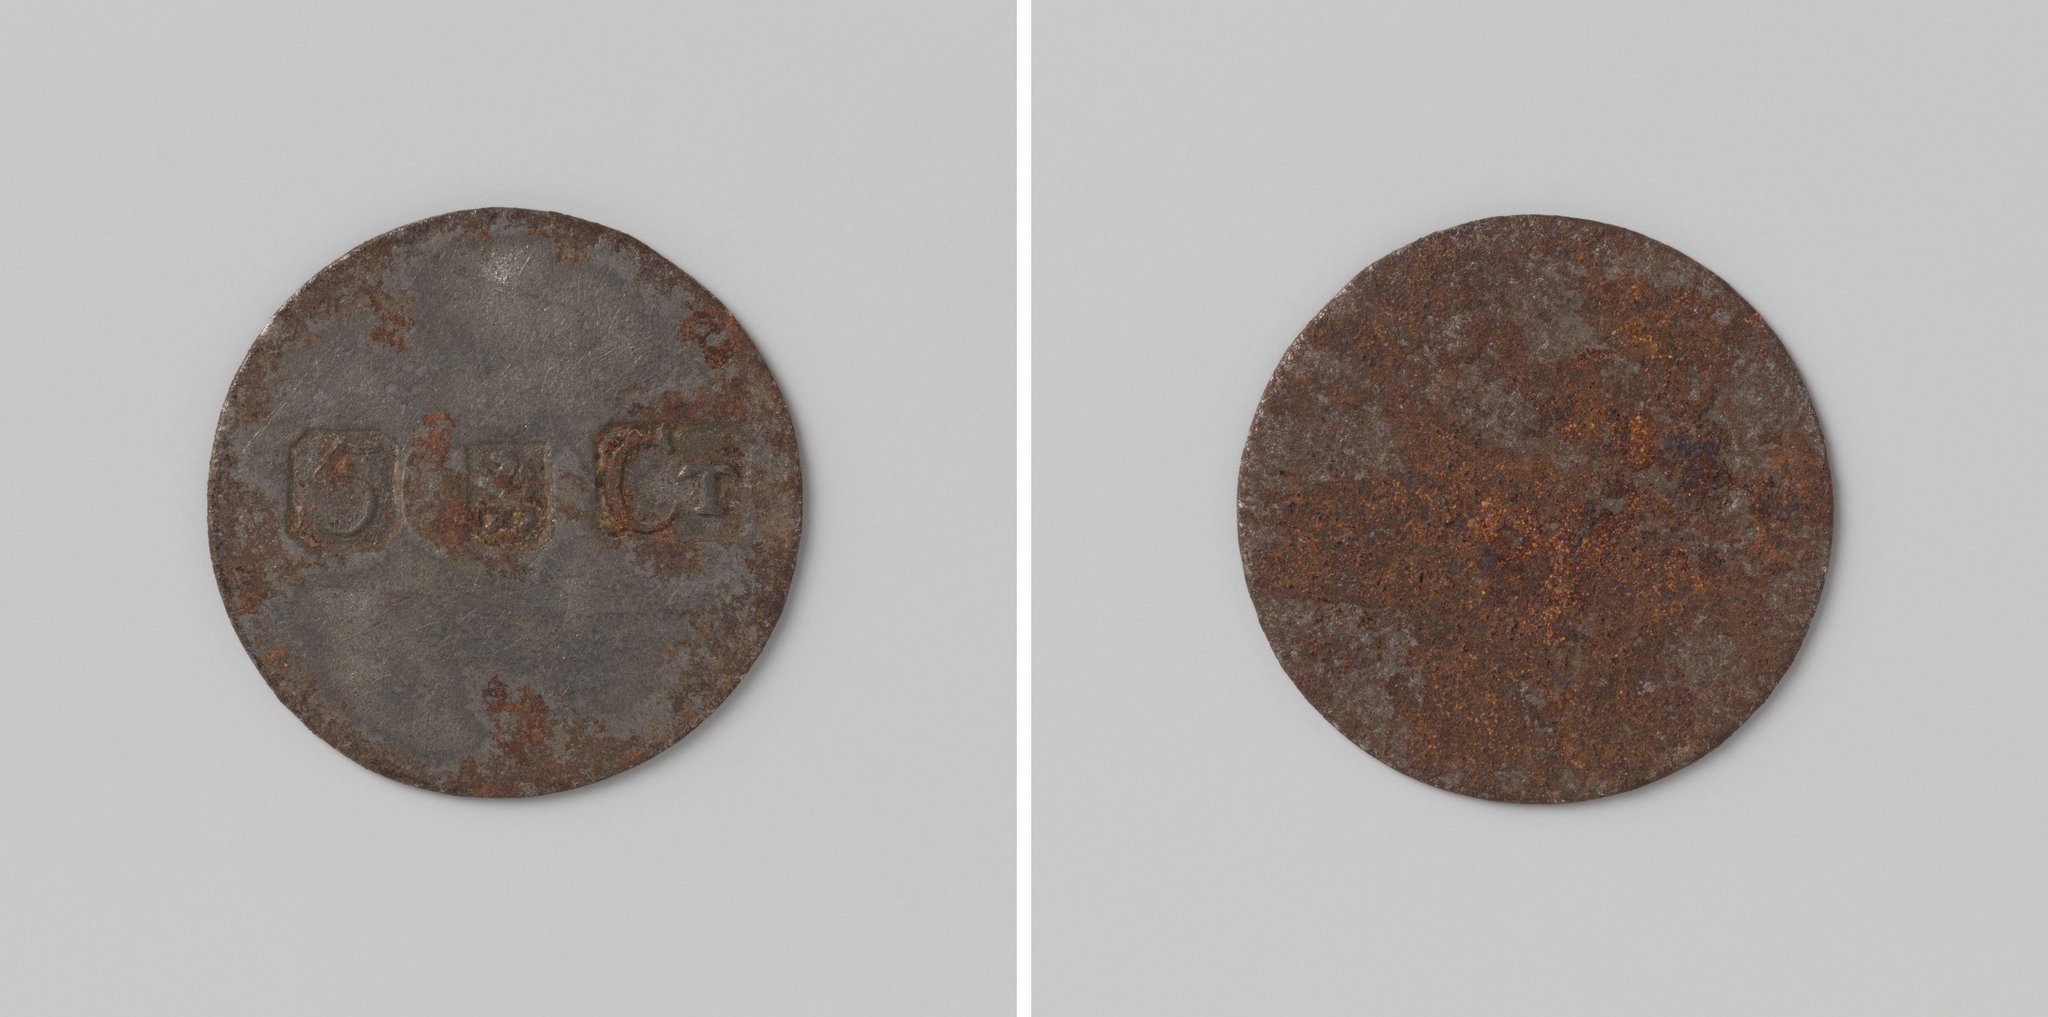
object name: huismunt prison money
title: Huis van reclusie en tuchtiging te Leeuwarden, huismunt ter waarde van vijf cent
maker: Anonymous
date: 1824-1847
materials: iron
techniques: striking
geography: leeuwarden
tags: leeuwarden